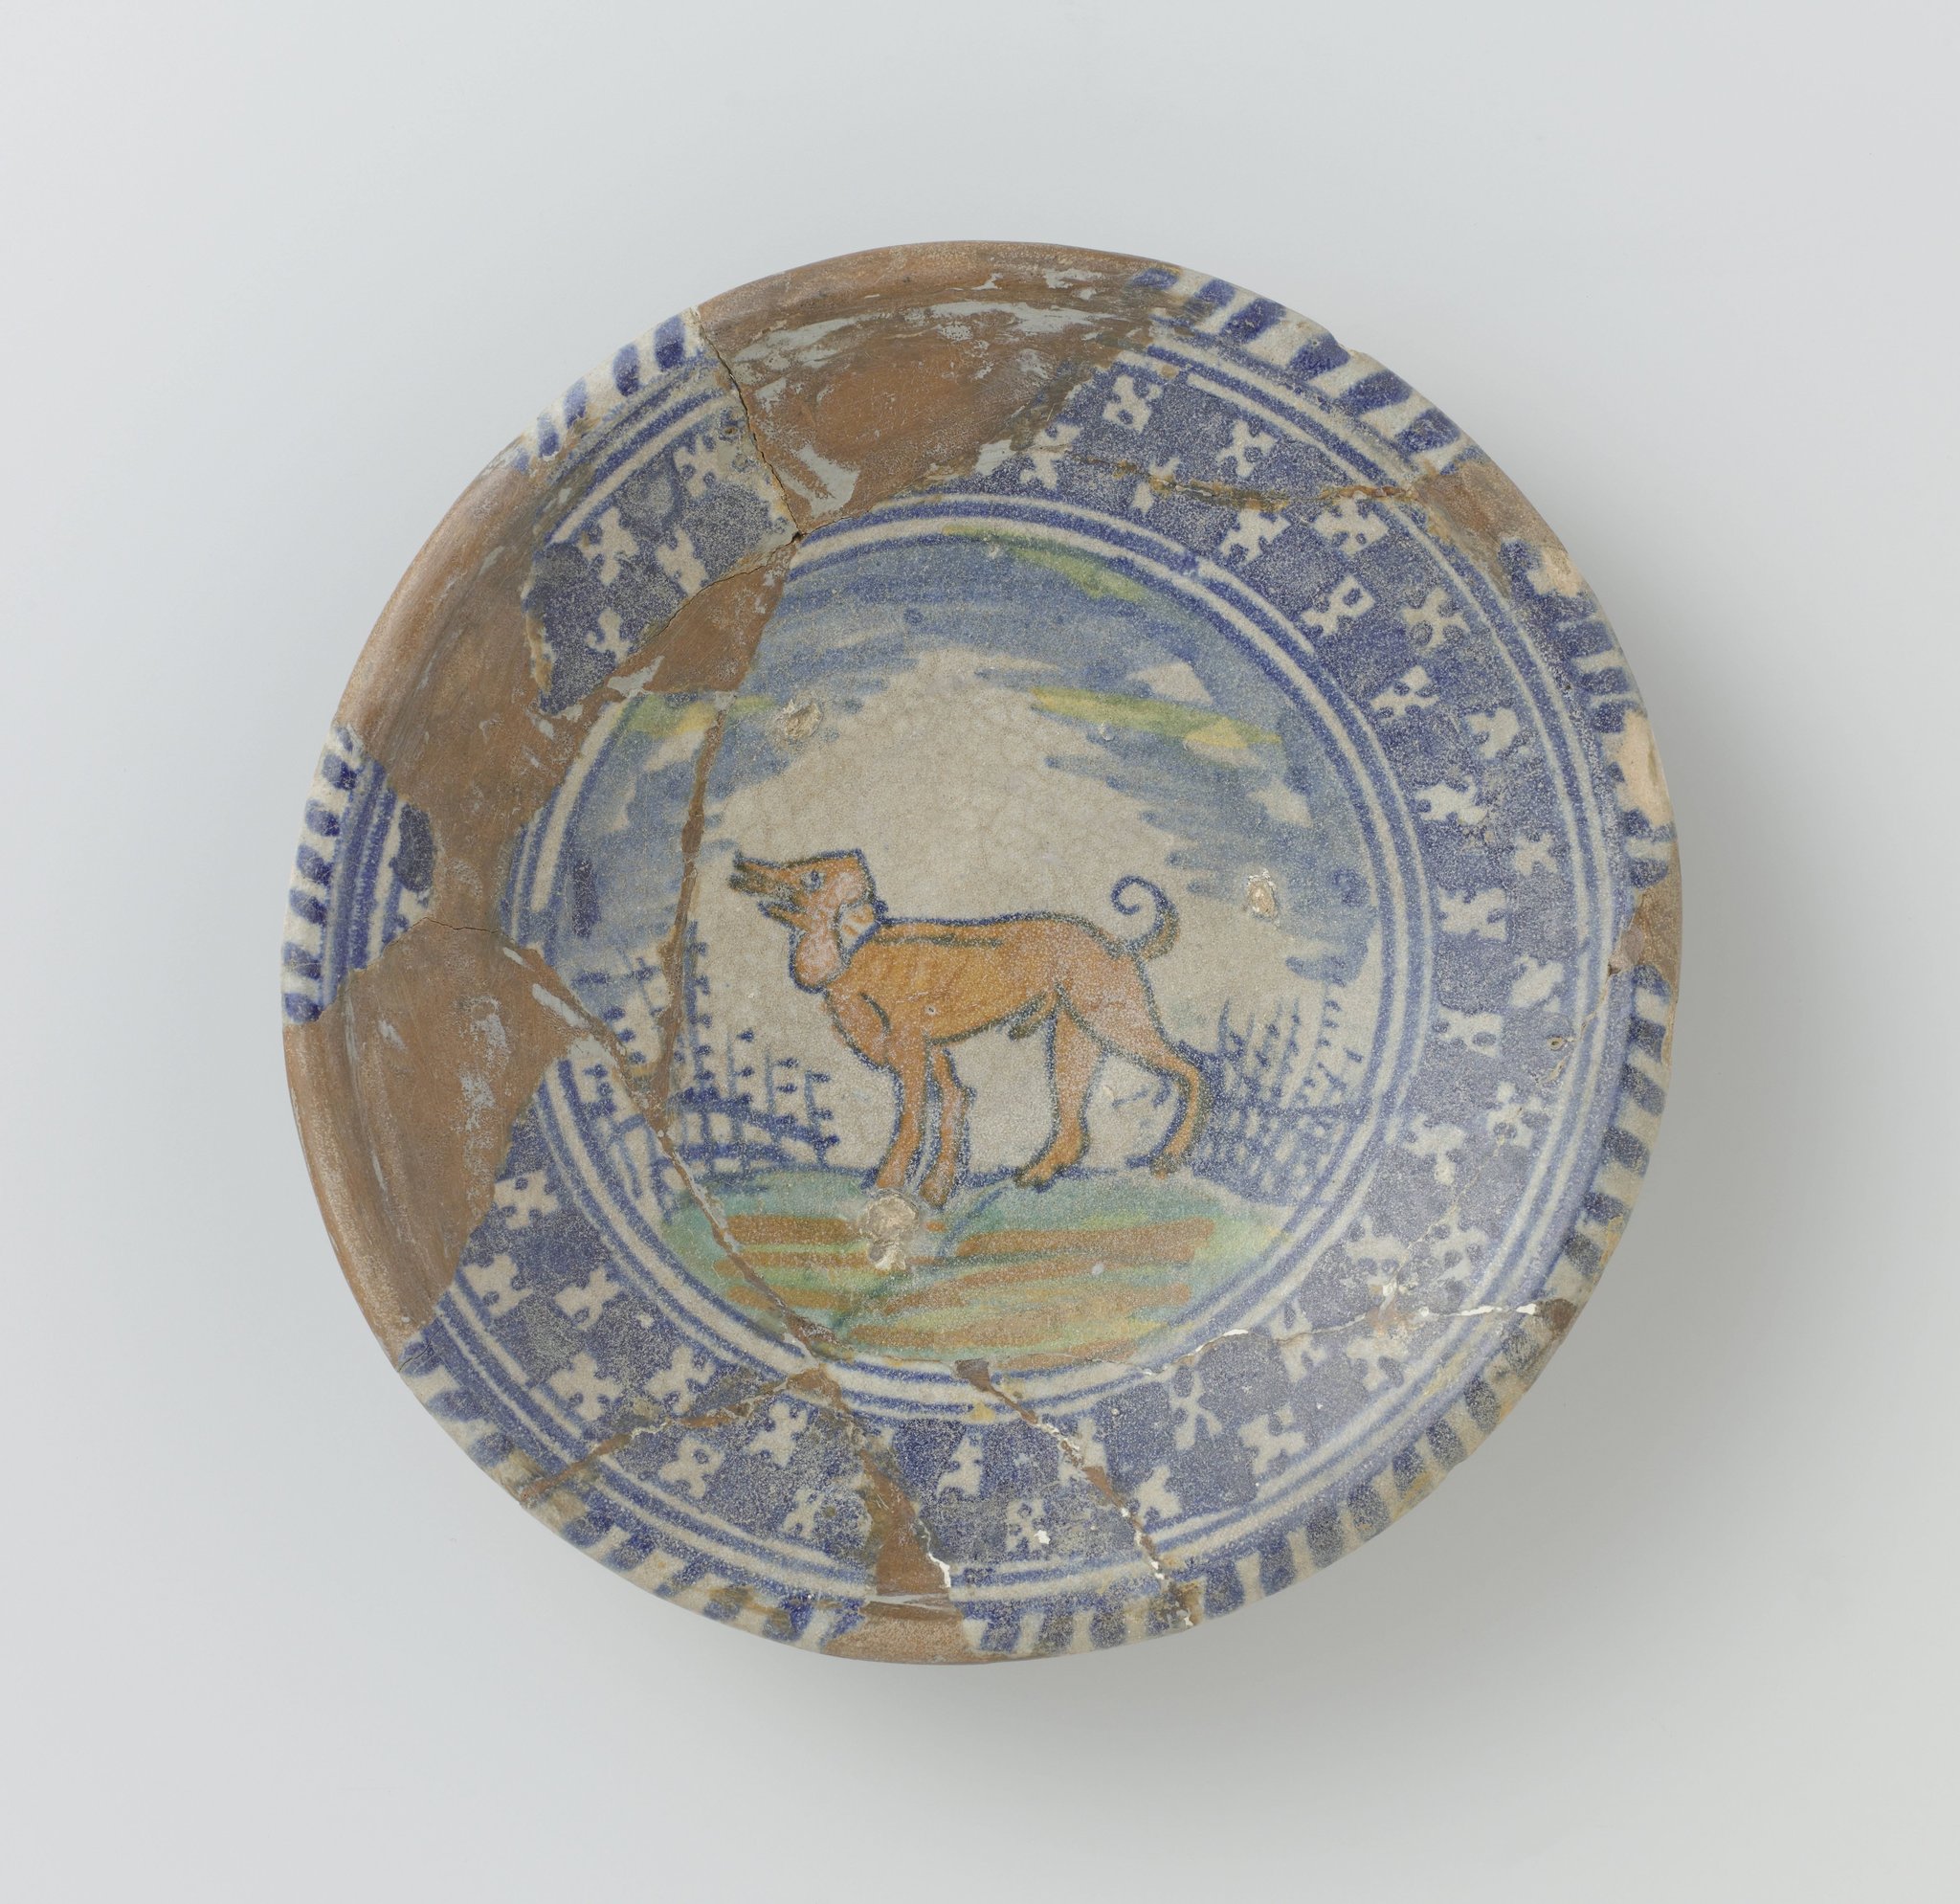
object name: platter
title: Schotel van veelkleurig beschilderd majolica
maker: Anonymous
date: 1575-1610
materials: earthenware, glaze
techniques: maiolica, painted, polychromy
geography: netherlands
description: Ronde schotel van veelkleurig beschilderde majolica. Op het plat is binnen een dubbele cirkel een hond op een grond geschilderd. De rand is beschilderd met een blauw-witte ruit (schaakbordmotief).